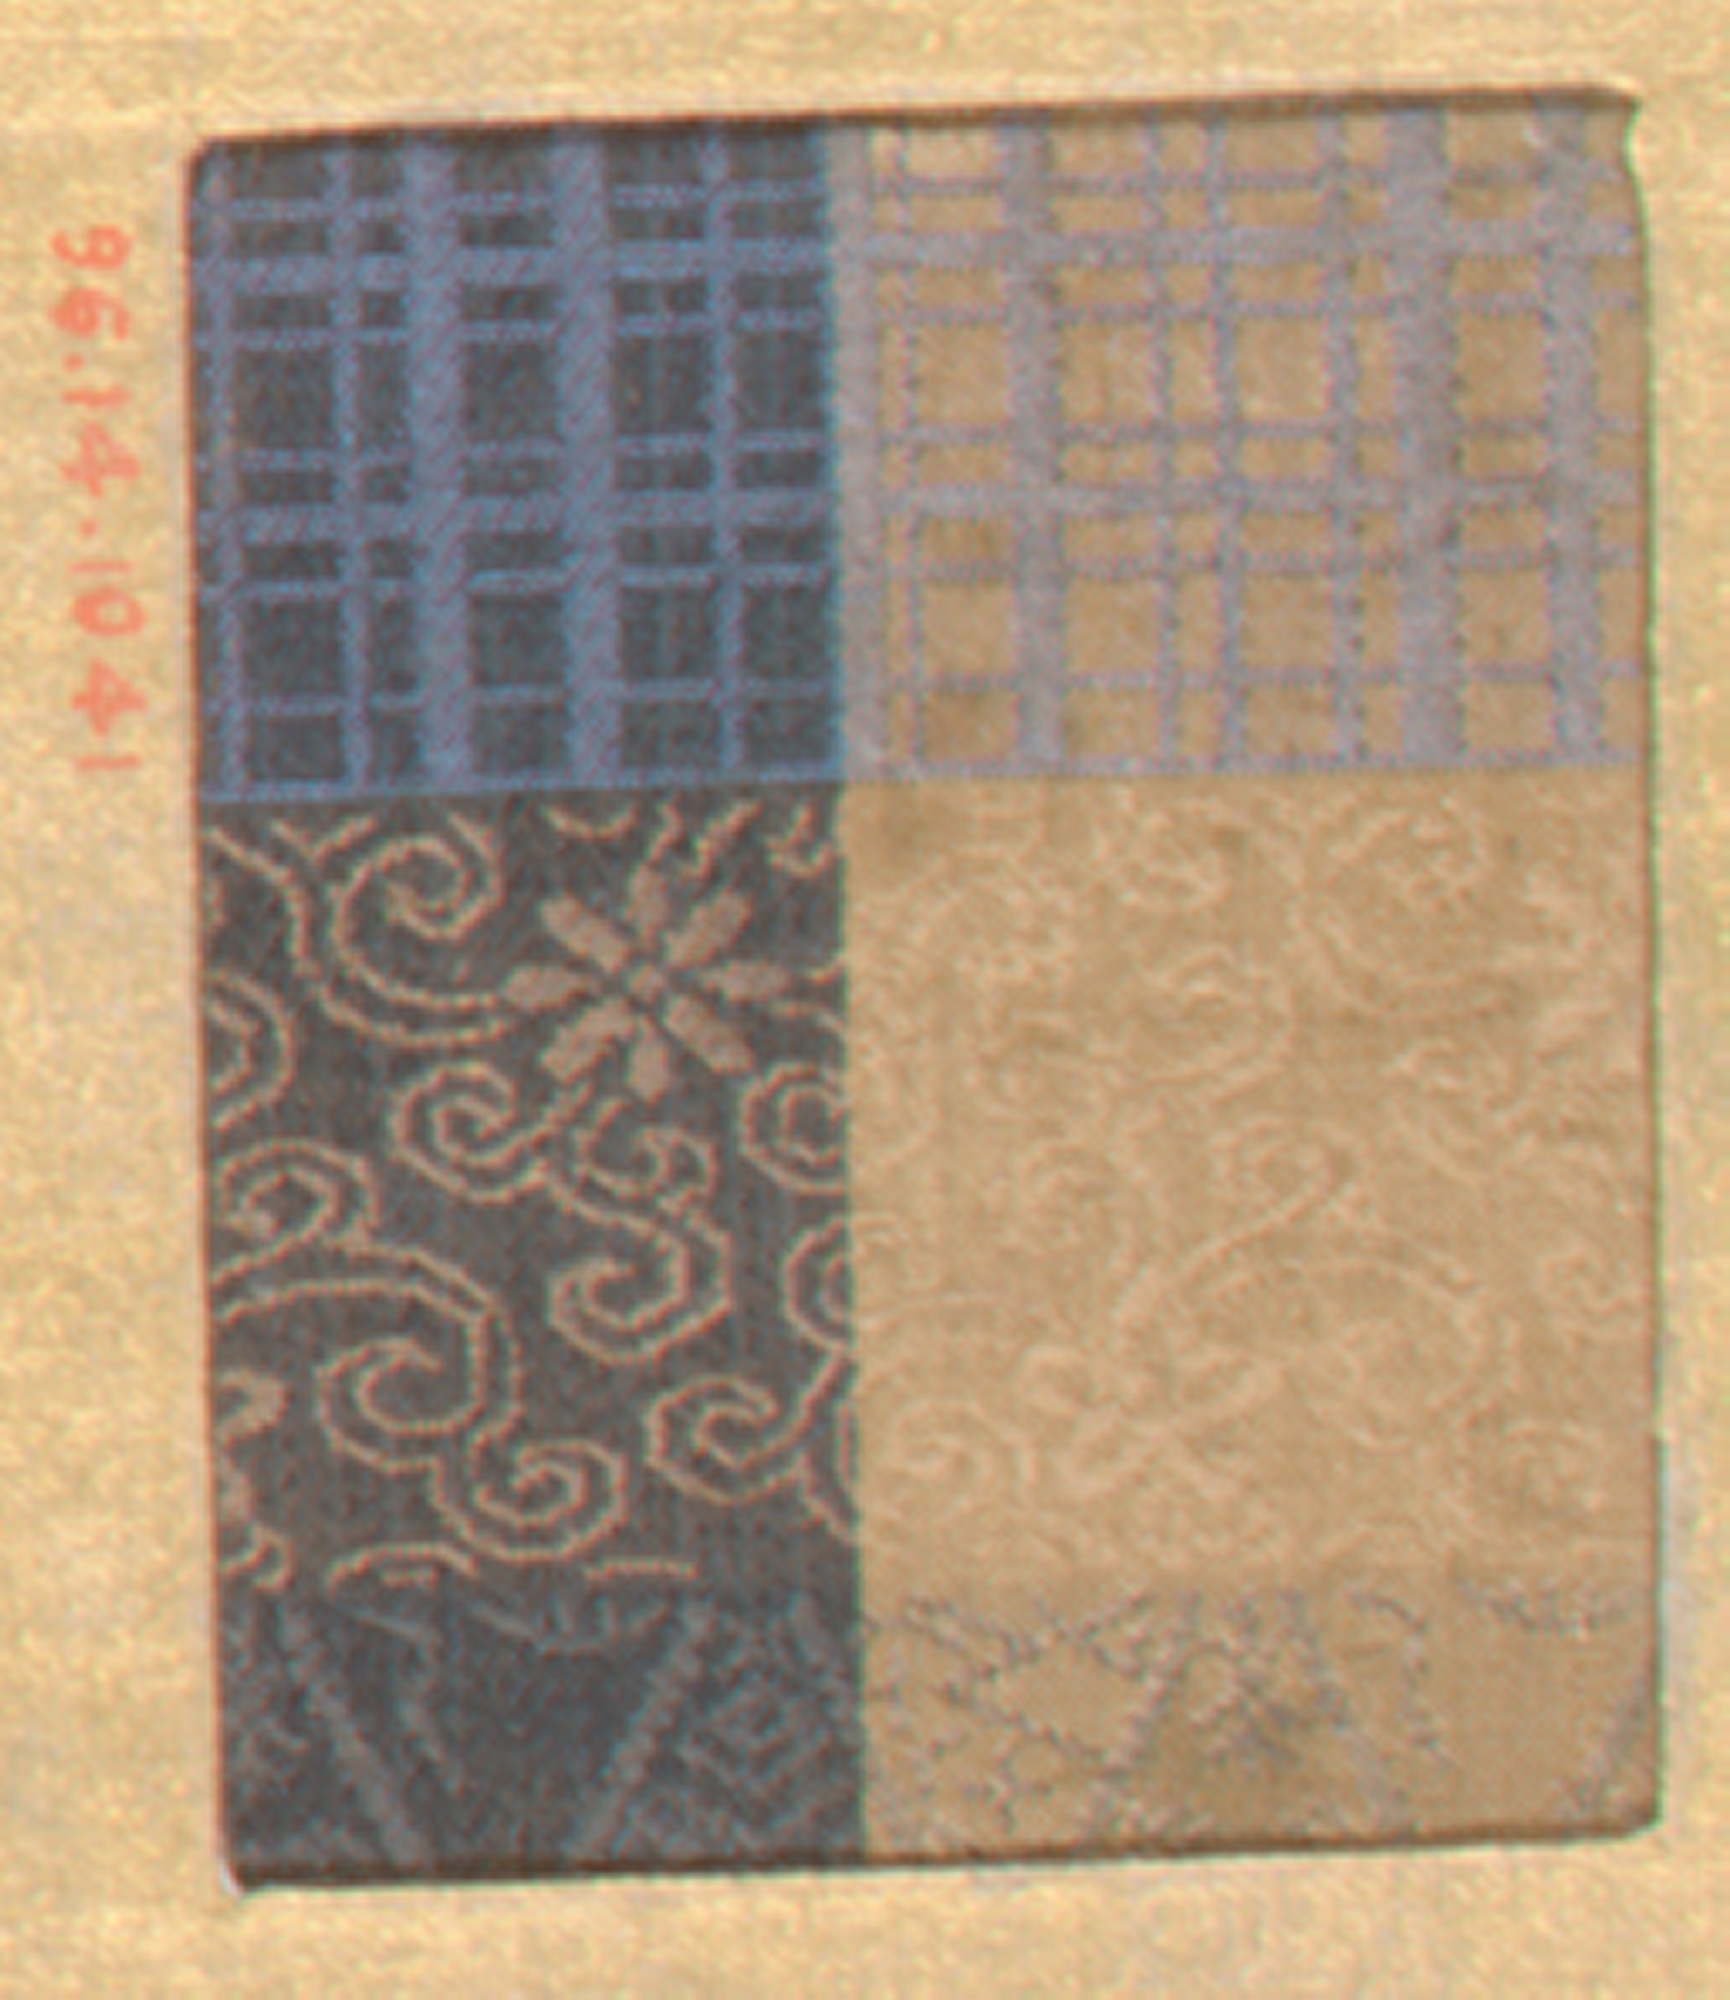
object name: piece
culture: japanese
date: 1701-1900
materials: silk